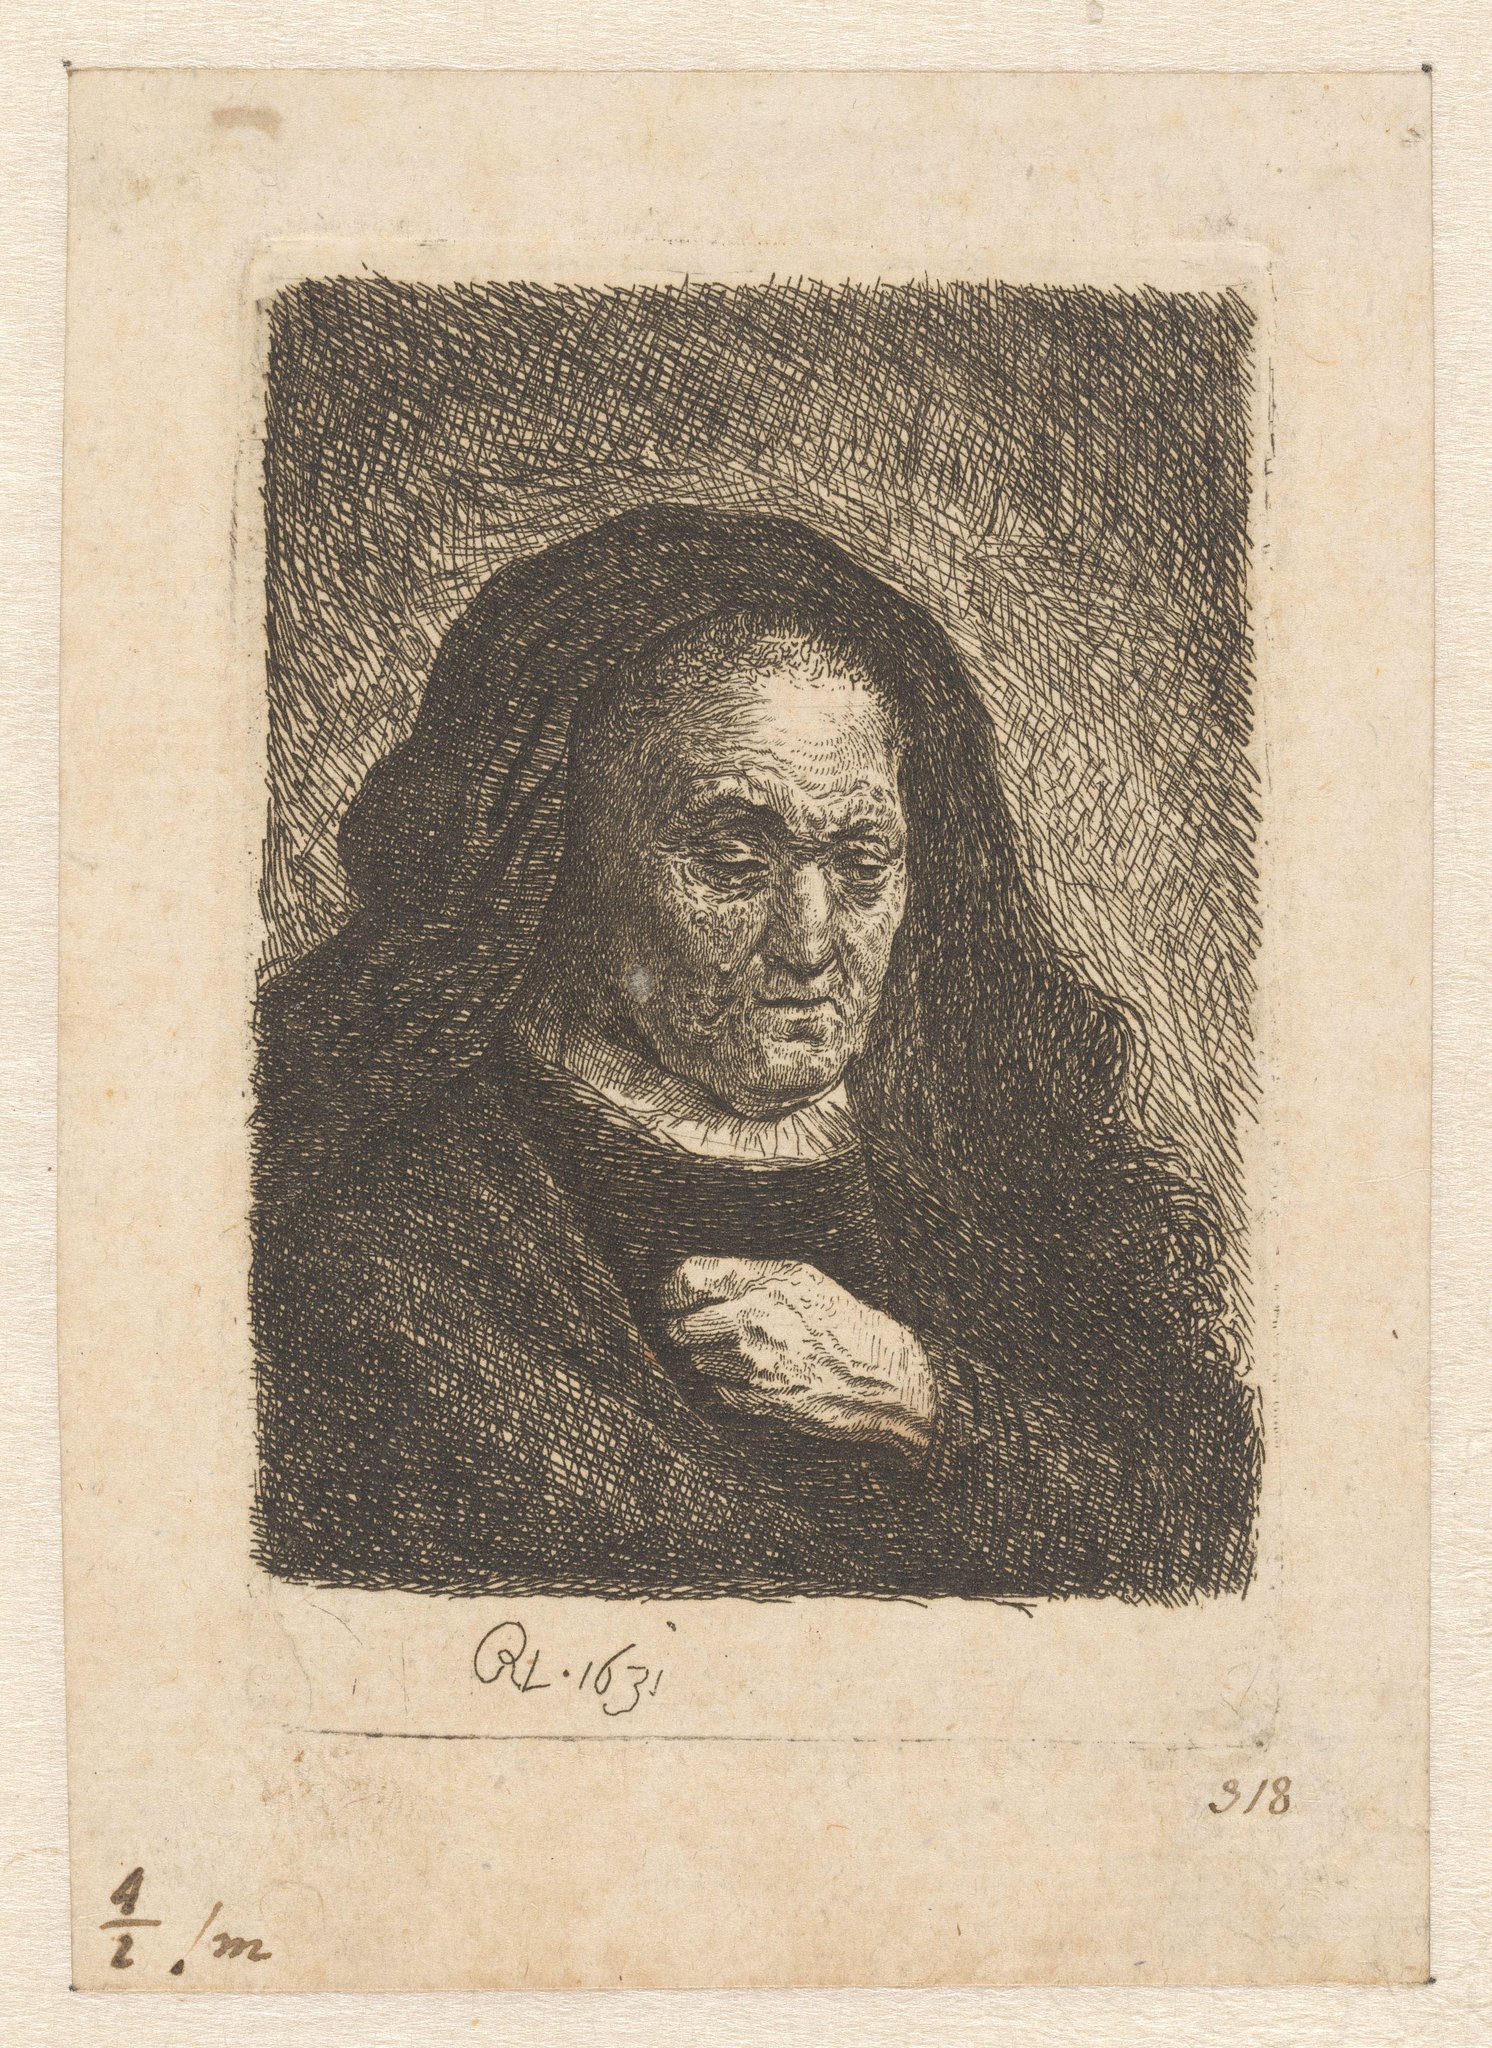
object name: print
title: The artist's mother with her hand on her chest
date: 1631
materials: paper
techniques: etching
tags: historical persons - bb - woman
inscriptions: collector's mark: Lugt 2228, stamp, collector's mark: Lugt 2760, number